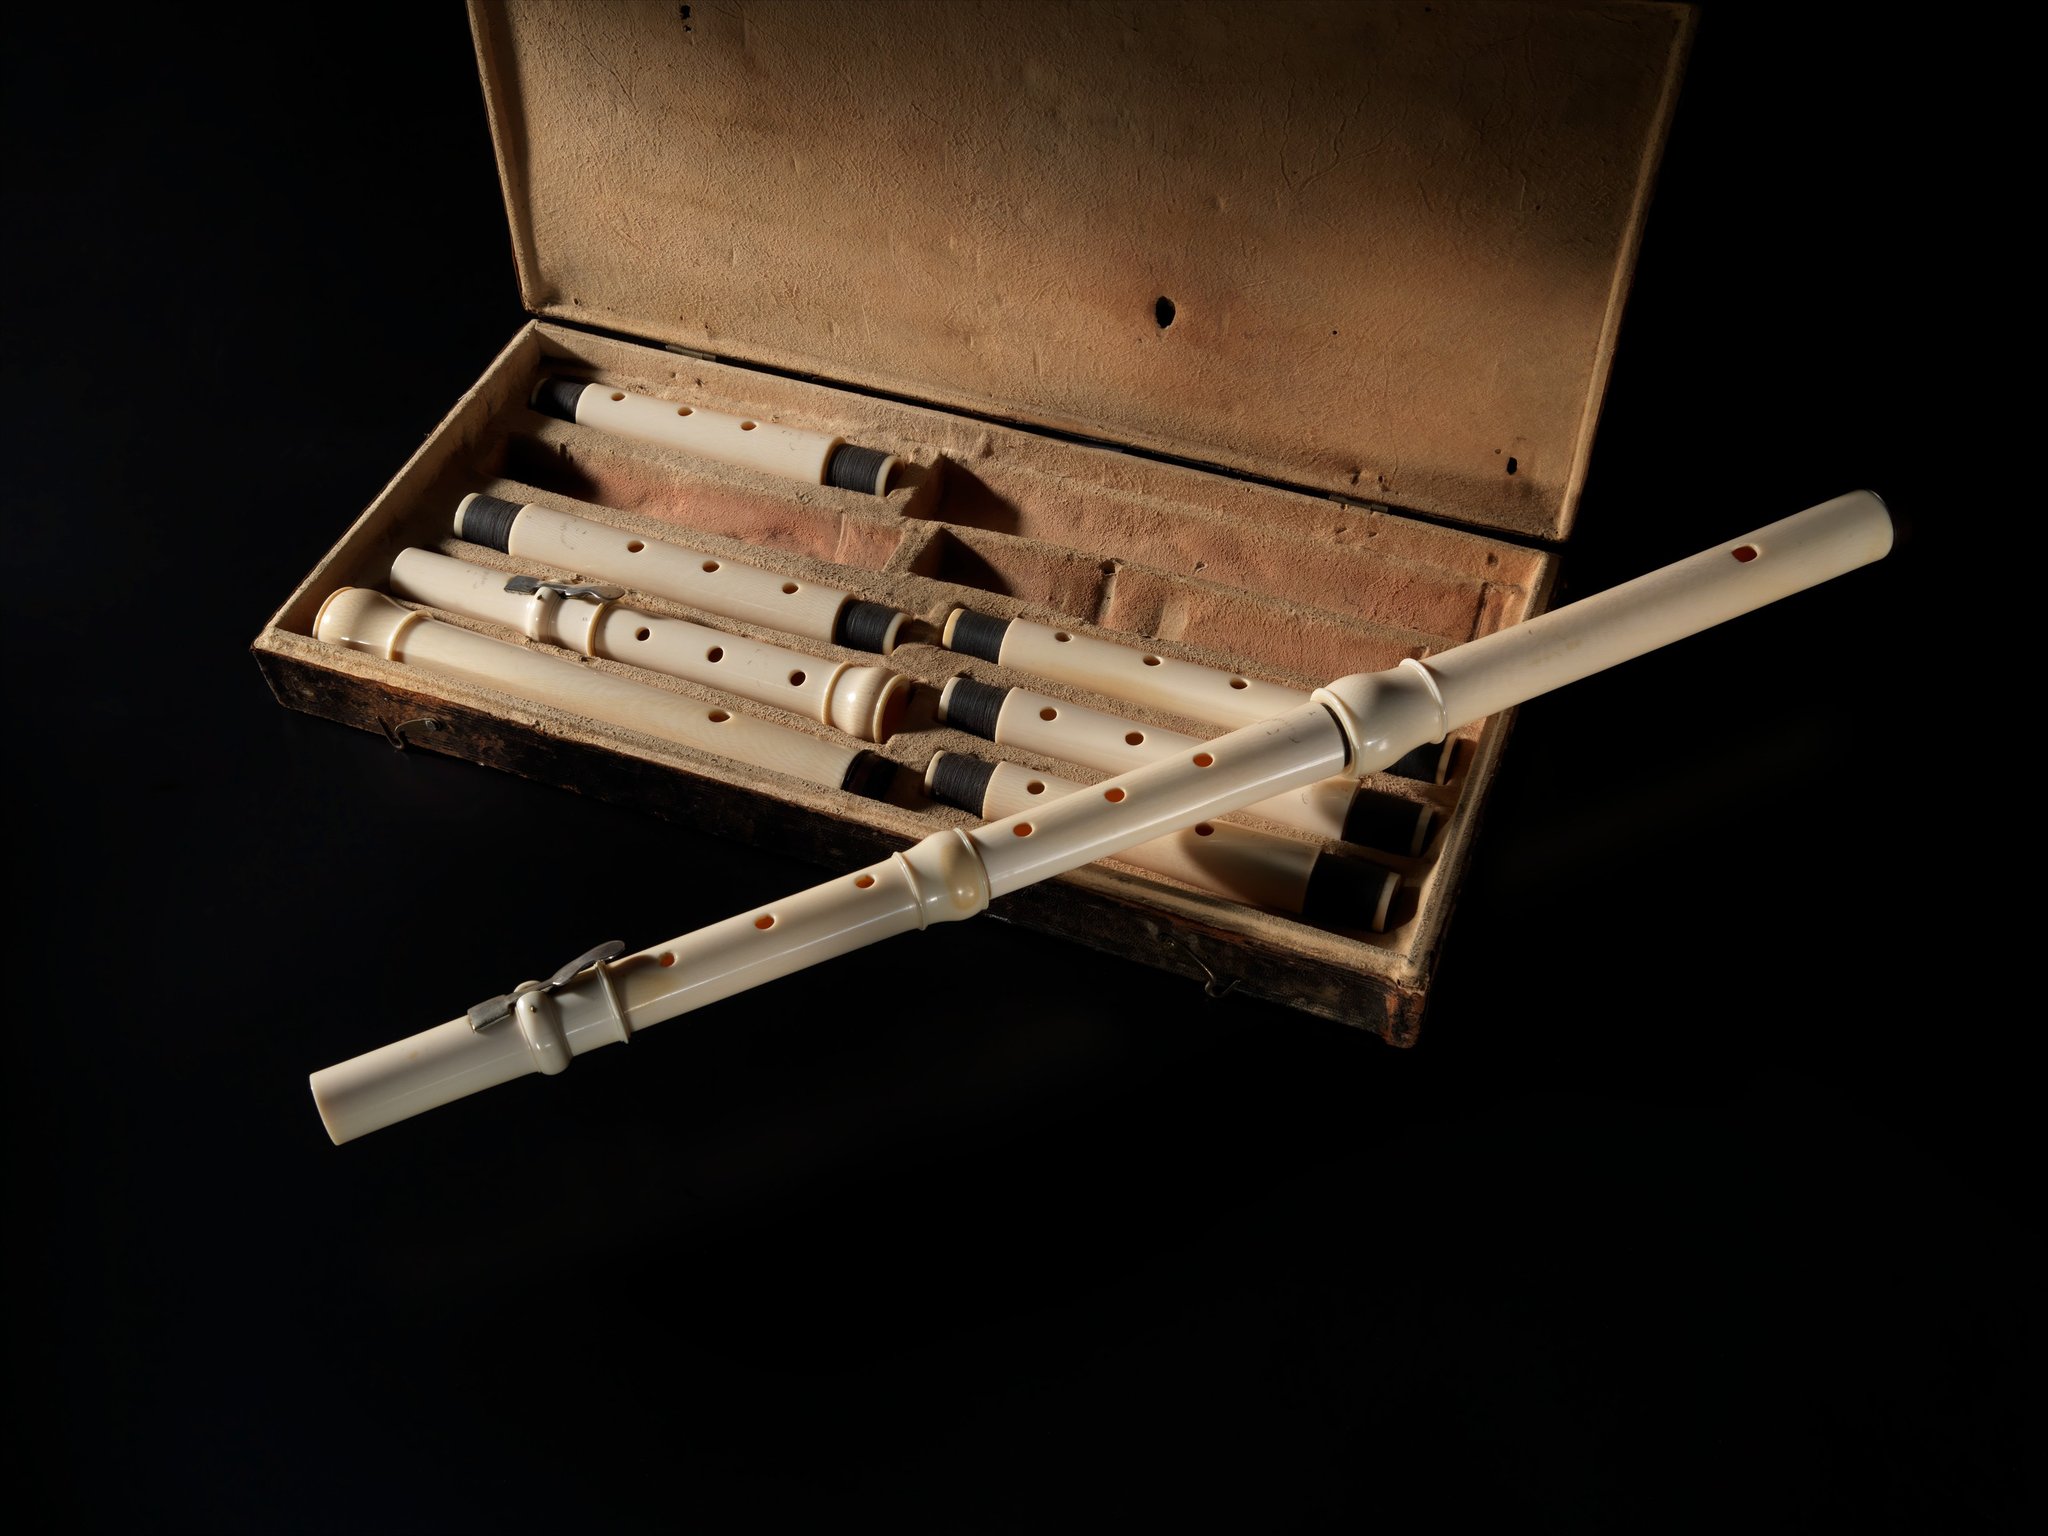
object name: pair of transverse flute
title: Pair of Transverse Flutes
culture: german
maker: johann wilhelm oberlender (the elder)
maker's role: maker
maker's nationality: german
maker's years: 1681-1763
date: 1734-1766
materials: ivory, silver, wood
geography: germany